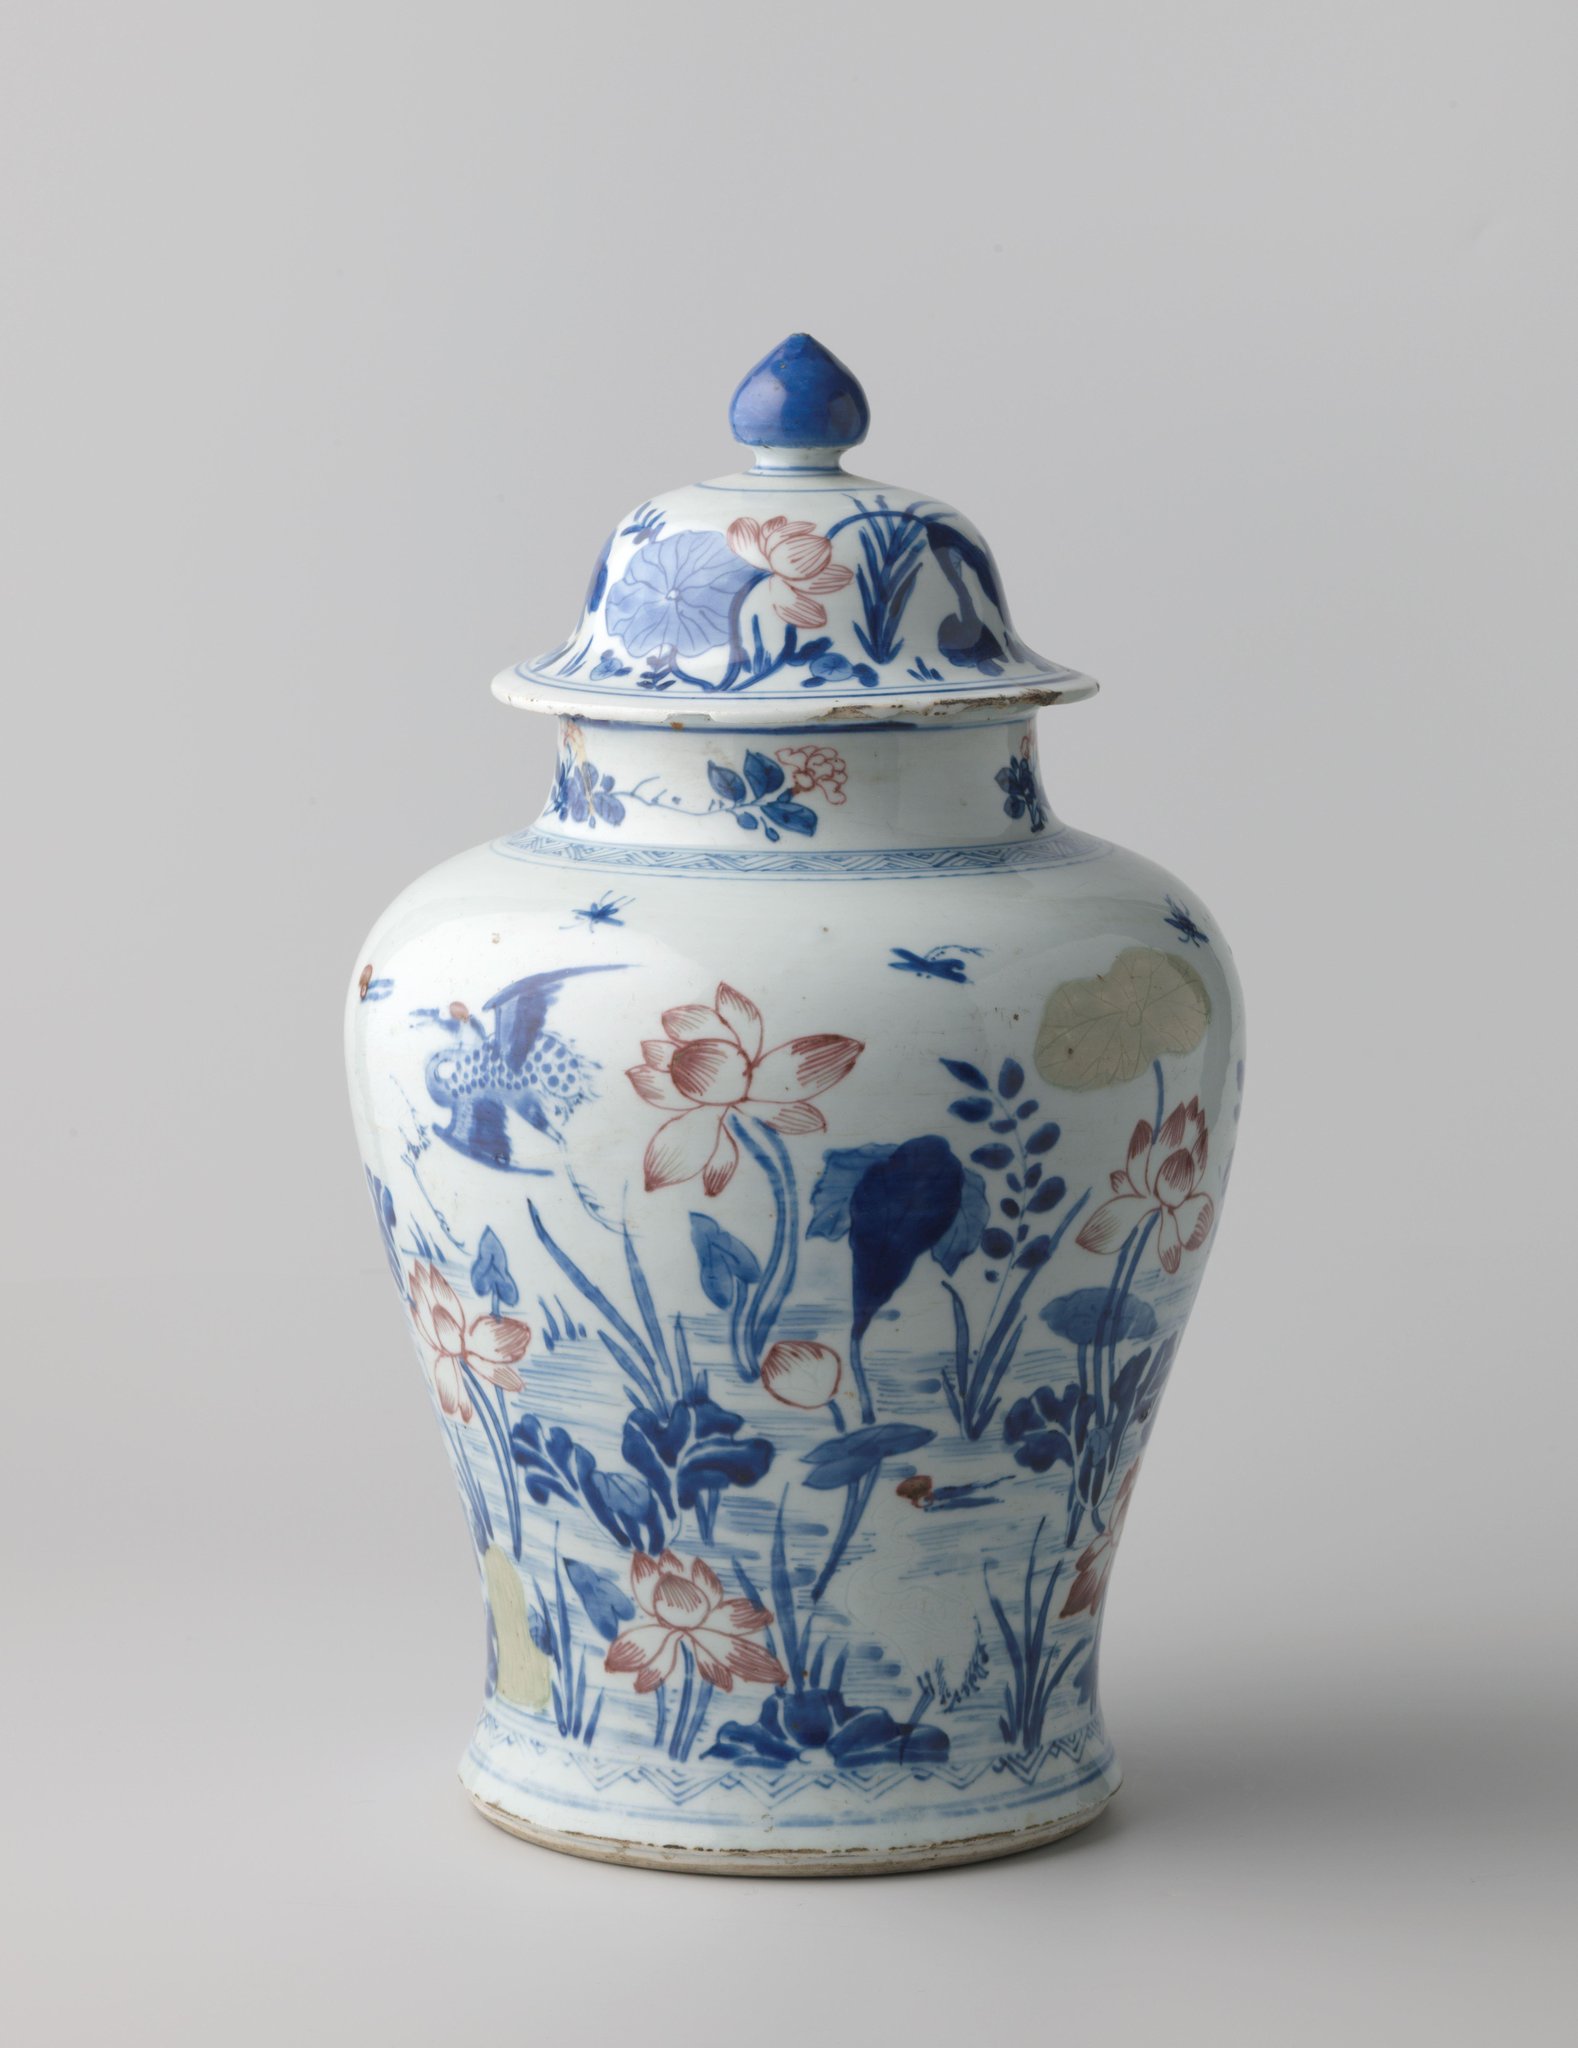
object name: pot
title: Baluster covered jar with lotus plants and cranes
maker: Anonymous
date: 1700-1724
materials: cobalt, copper, glaze, paint, porcelain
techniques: firing, turning, vitrification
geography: china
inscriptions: mark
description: Balustervormige dekselpot van porselein met een spreidende voet en een brede hals. Beschilderd in onderglazuur blauw en rood en een wit slib. Op de wand een doorlopende voorstelling van een vijver met lotusplanten en staande en vliegende kraanvogels. Rond de voet en op de schouder een decoratieve band. De hals met bloemtakken. Gemerkt op de onderzijde met een artemisiablad in een dubbele cirkel. Een barst in de hals van de pot. Onderglazuur blauw met koperrood.